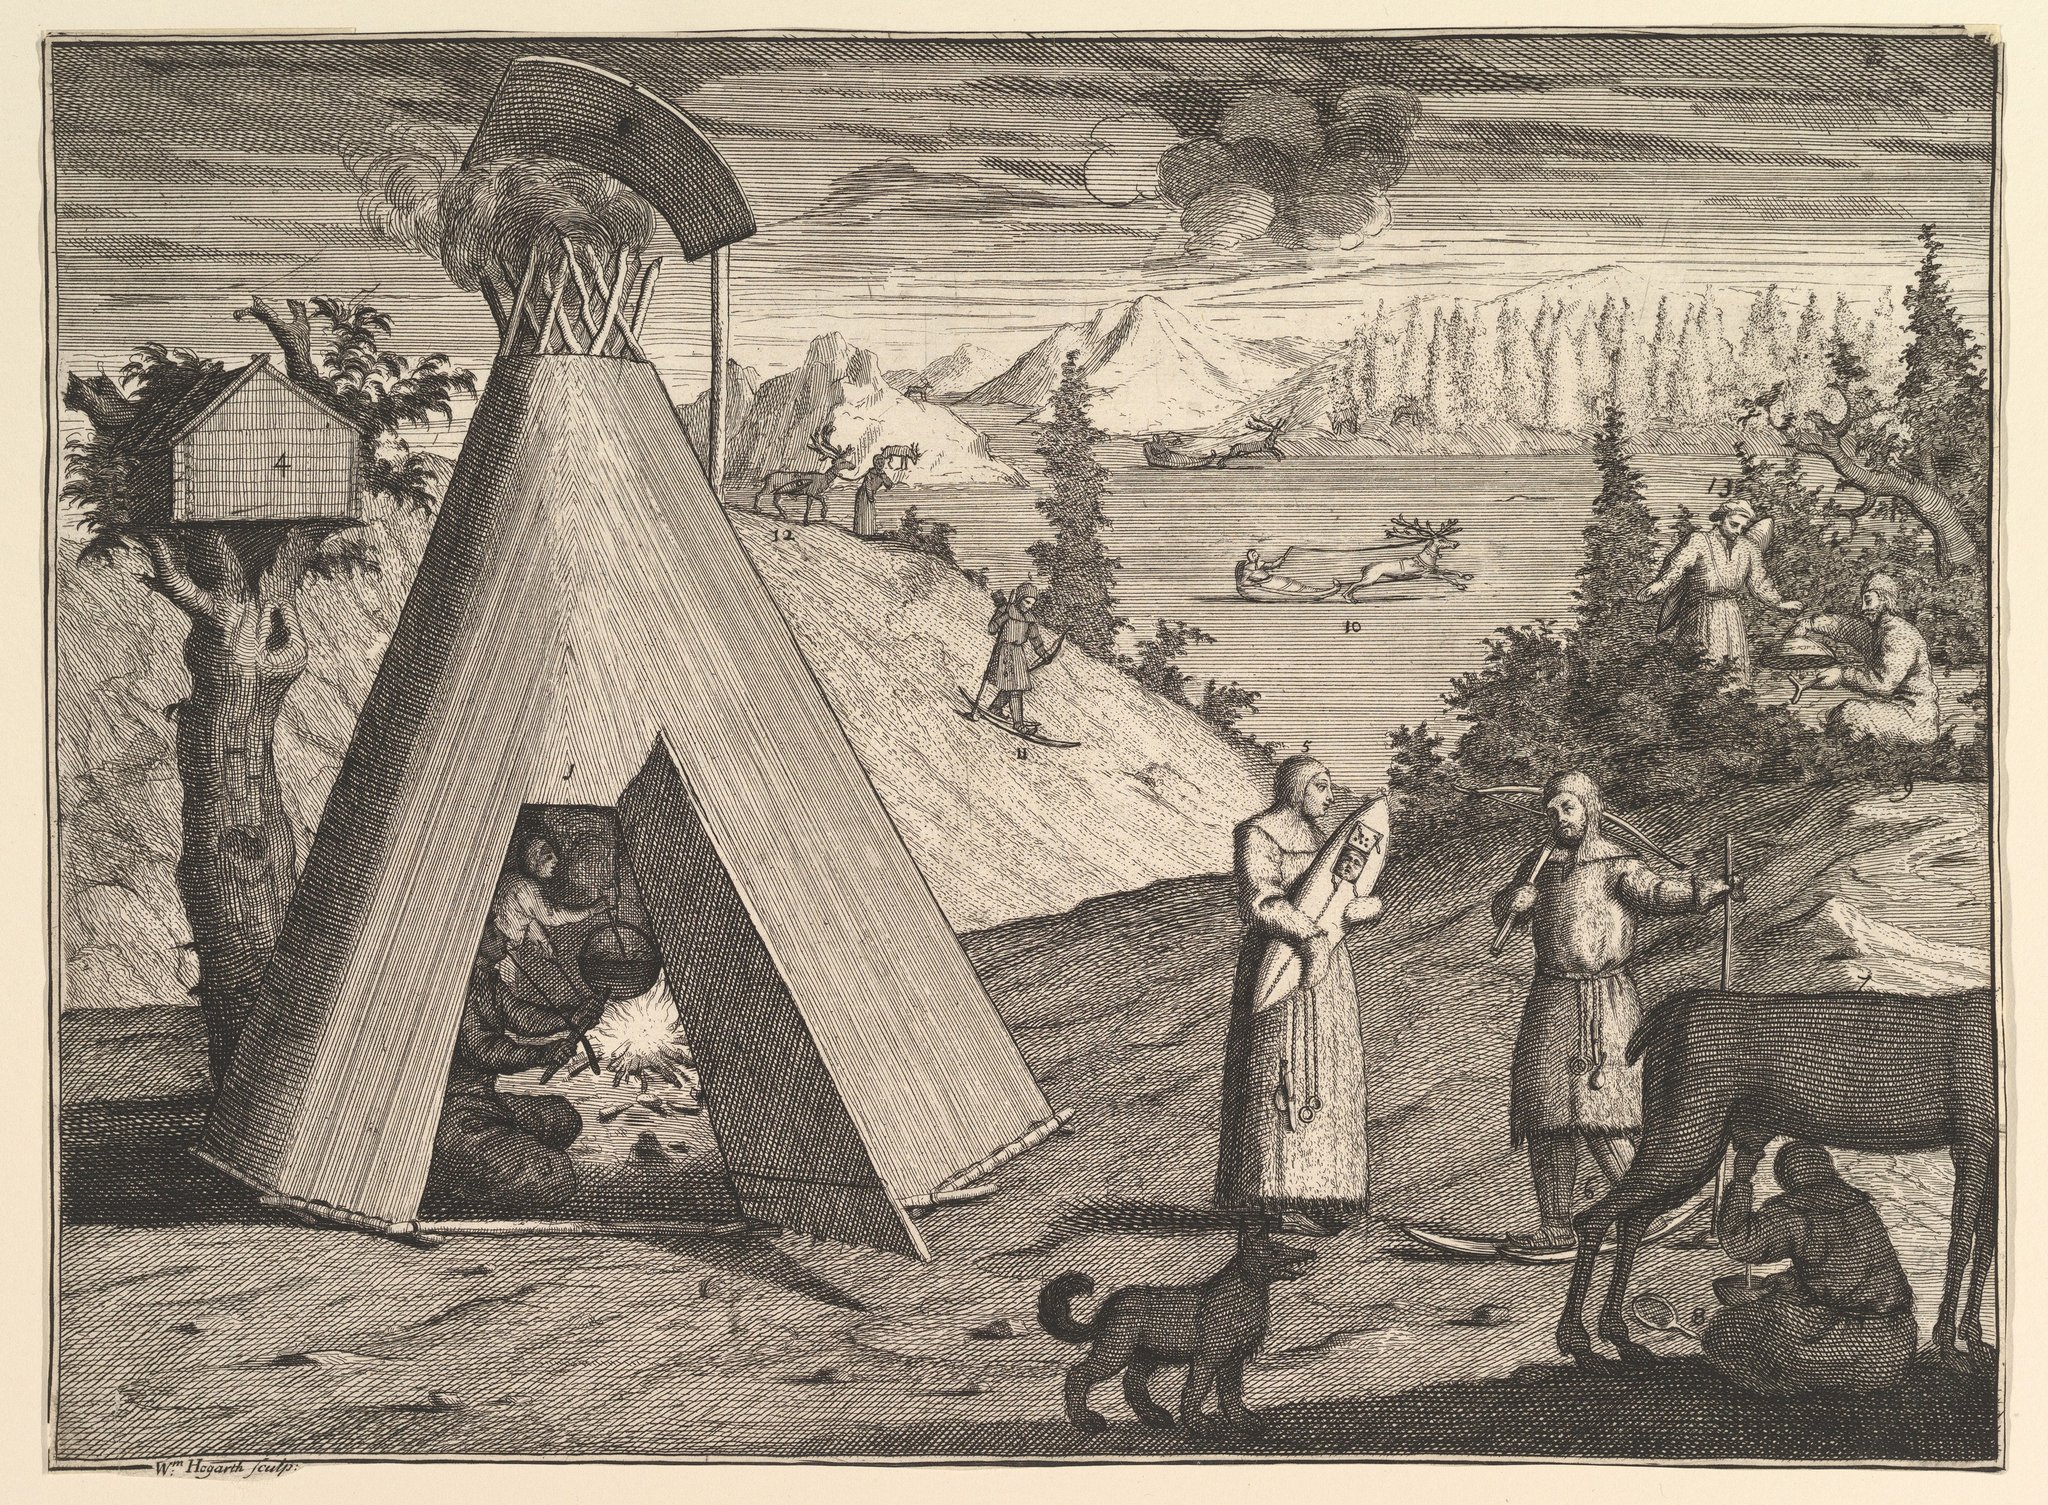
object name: print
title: A Lapland Hut (Aubry de La Mottraye's "Travels throughout Europe, Asia and into Part of Africa...," London, 1724, vol. II, pl. 38)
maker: william hogarth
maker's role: artist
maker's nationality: british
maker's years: 1697-1764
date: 1723-1724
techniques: engraving, etching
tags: animals,houses,men,women,landscapes